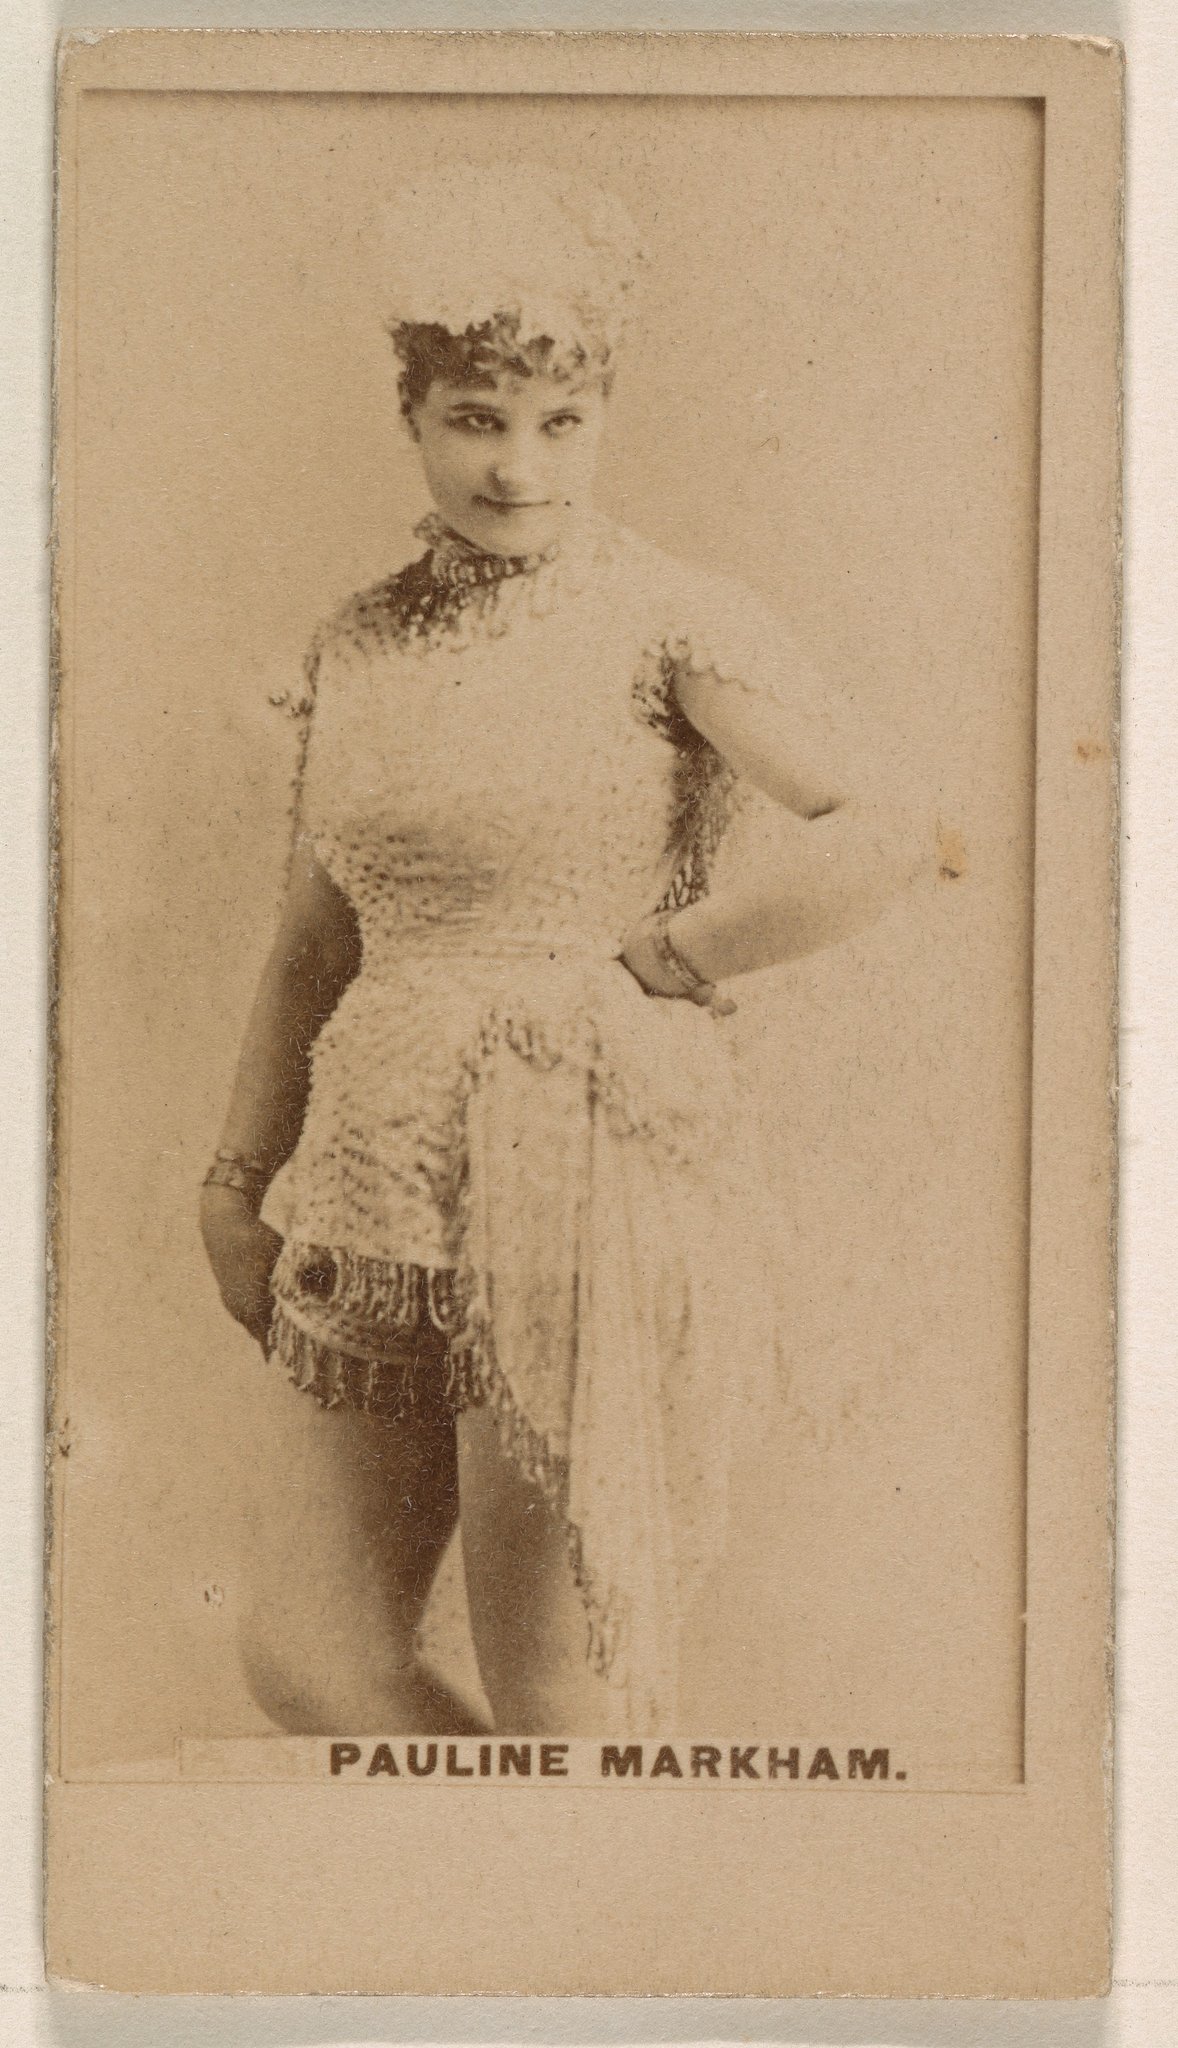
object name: photograph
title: Pauline Markham, from the Actresses series (N245) issued by Kinney Brothers to promote Sweet Caporal Cigarettes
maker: kinney brothers tobacco company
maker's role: publisher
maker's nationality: american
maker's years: 1869-2011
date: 1890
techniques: albumen silver print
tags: portraits,women,actresses